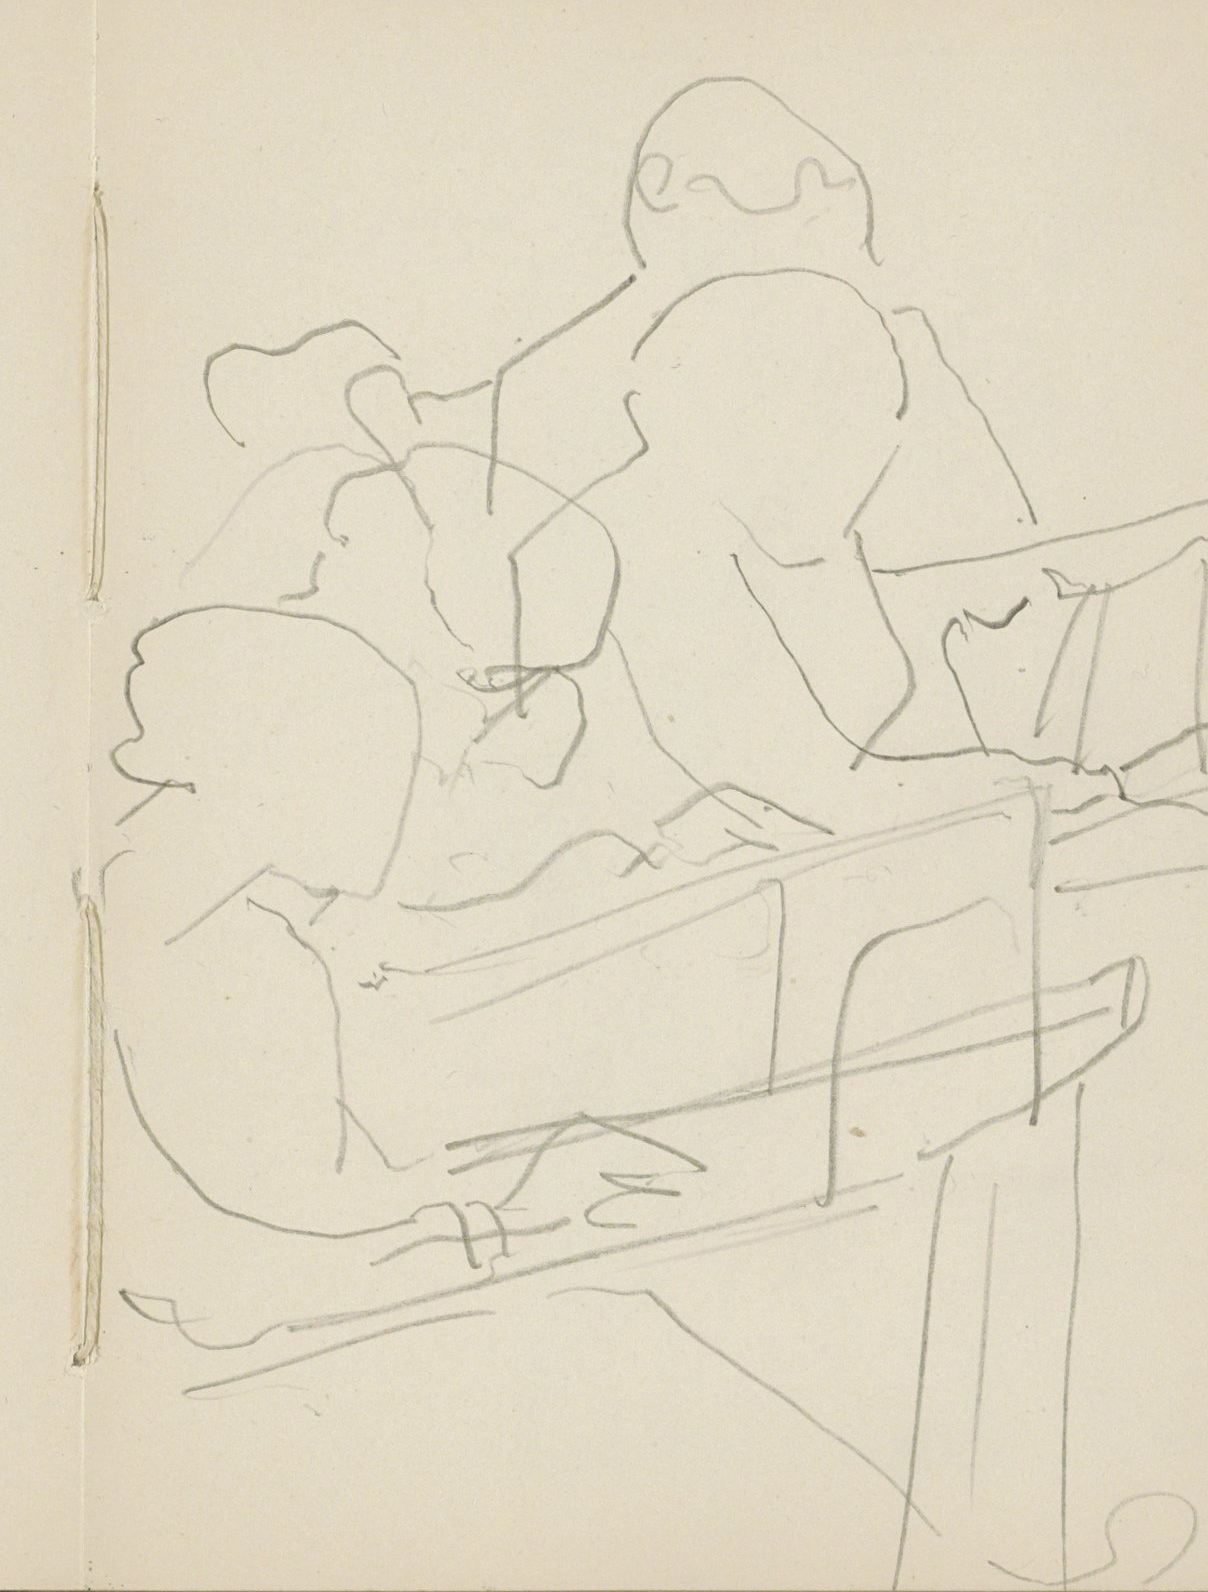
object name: sketchbook leaf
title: Vier figuren in een tekenklas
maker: reijer stolk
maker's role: draughtsman, print maker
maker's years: 1896-1945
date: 1906-1945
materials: paper, pencil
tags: drawing-lesson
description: De personen zitten op een rij achter tekentafels. Blad 8 recto uit een schetsboek met 69 bladen.